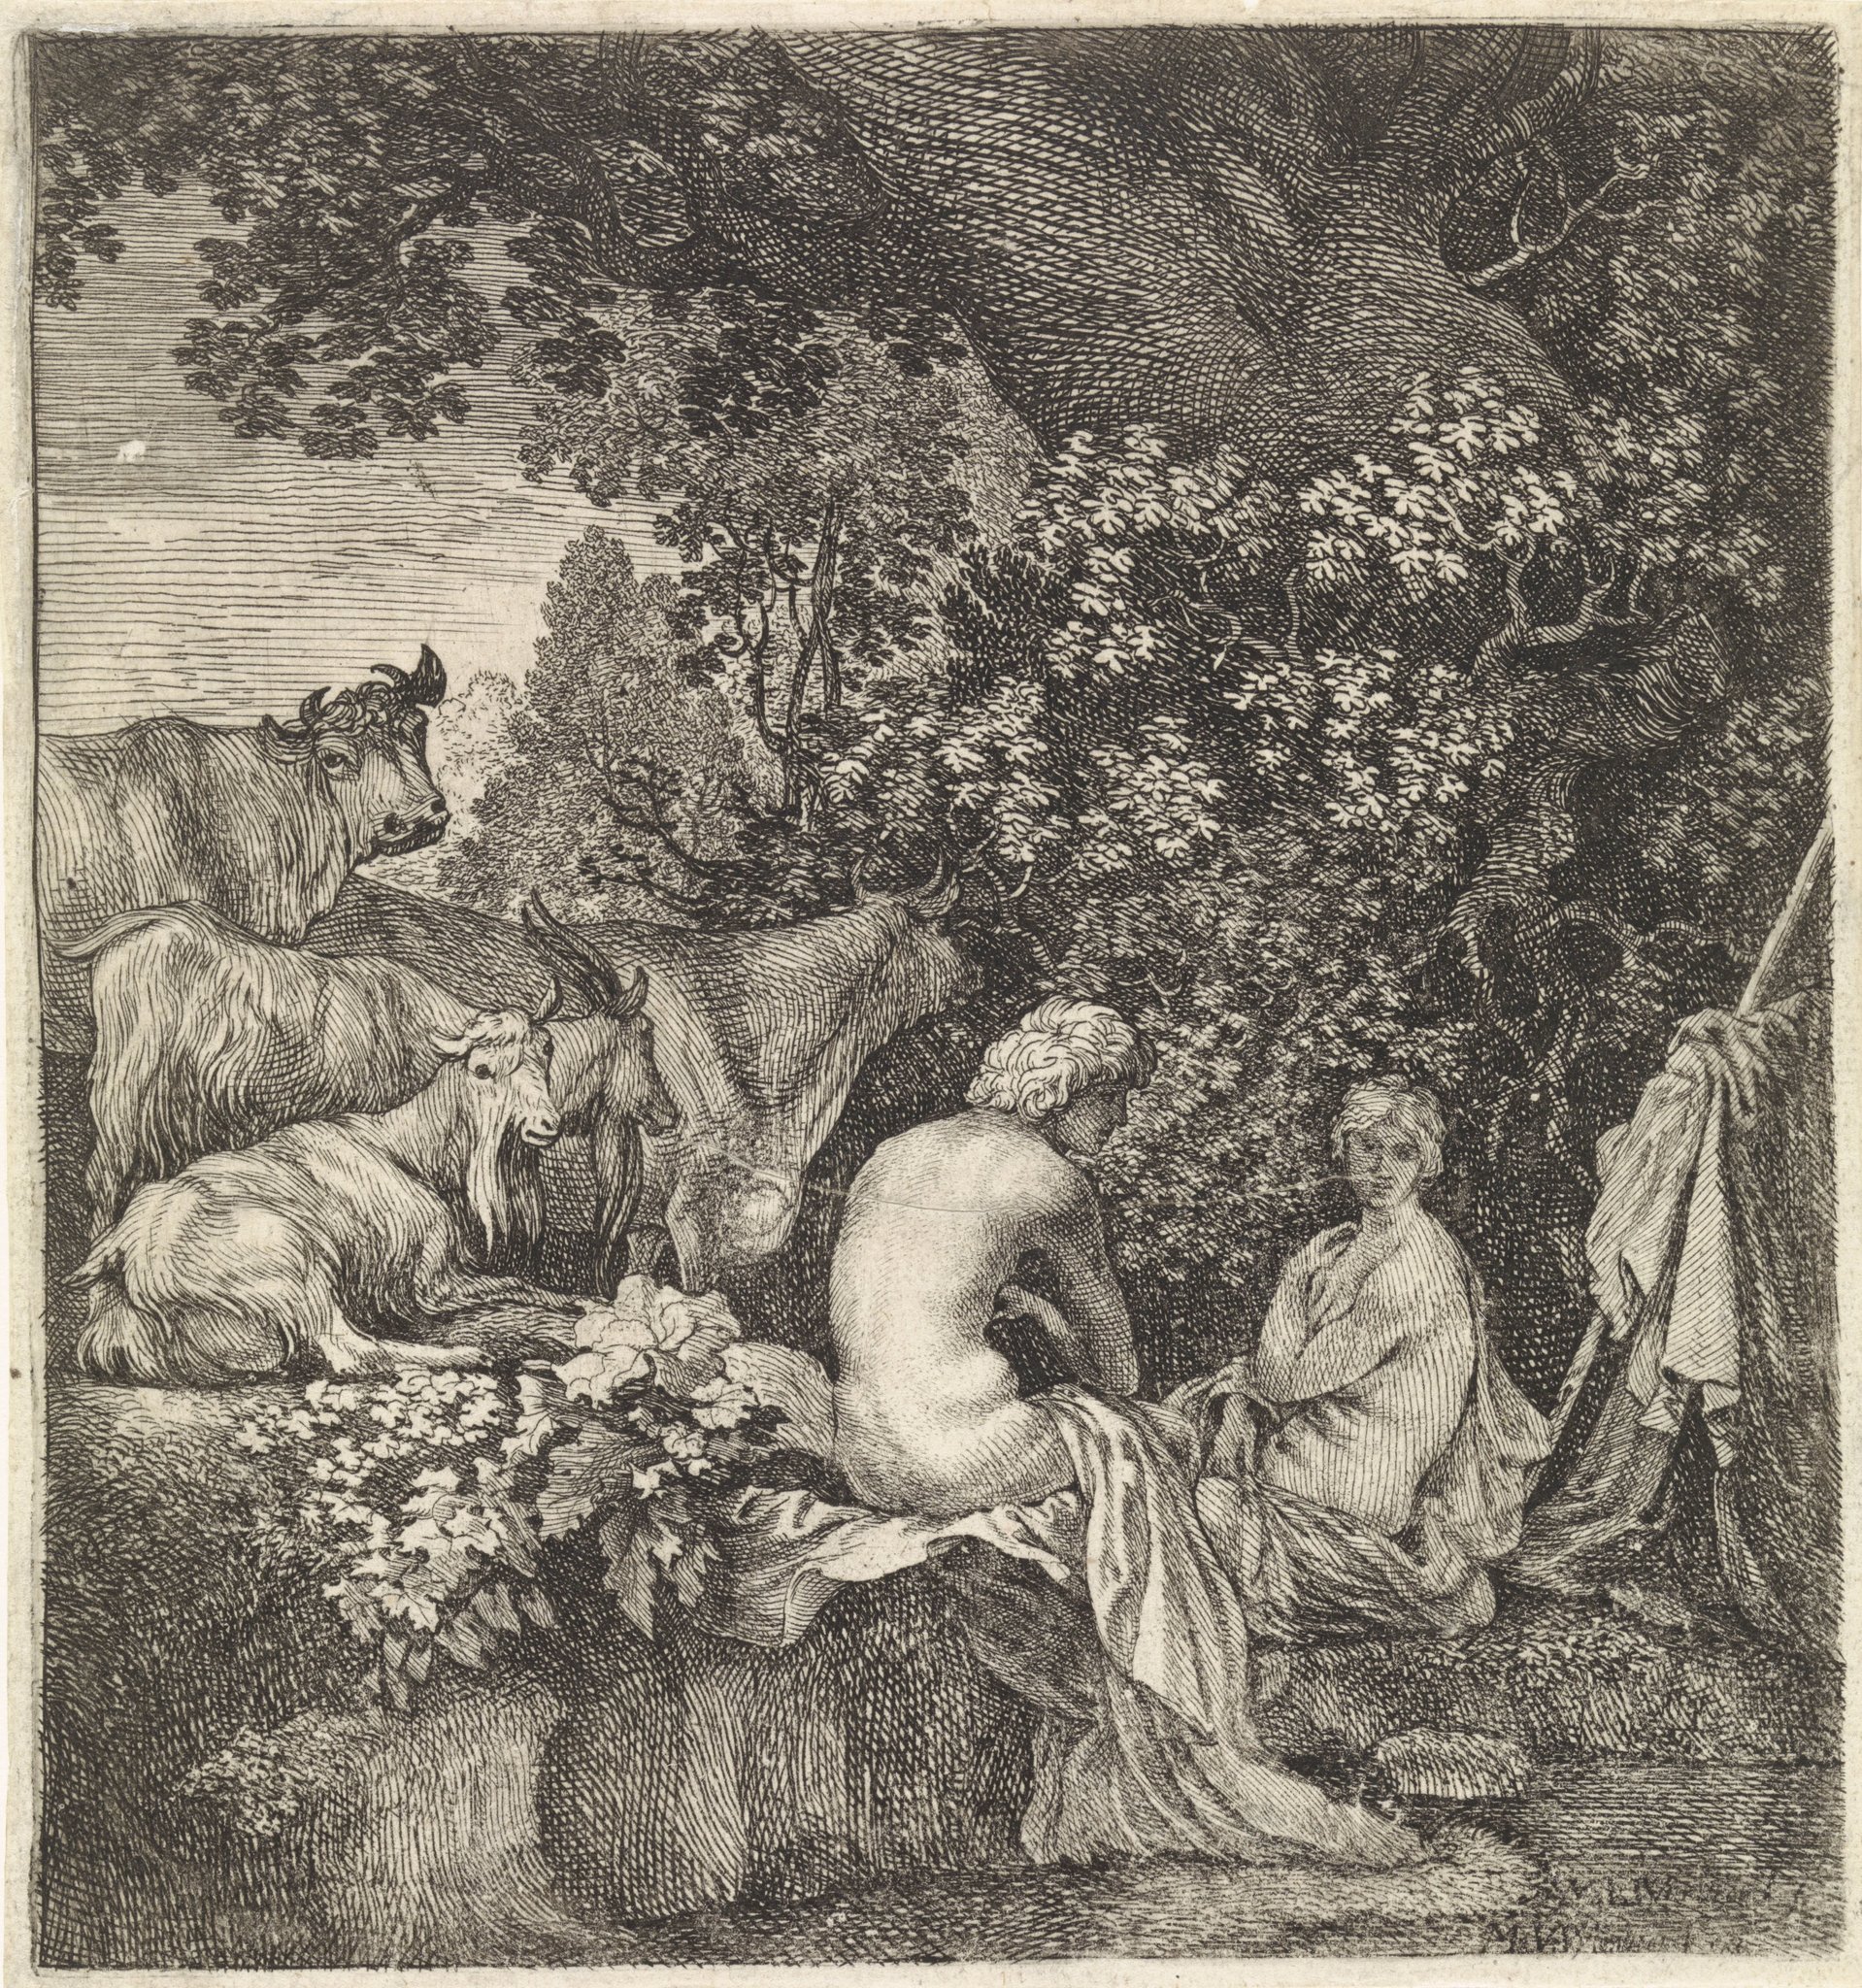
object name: print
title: Herders bij een vijver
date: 1600-1647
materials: paper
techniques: engraving, etching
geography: antwerp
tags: pond, pool, pastorals, arcadian scenes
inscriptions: collector's mark: Lugt 240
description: Een naakte man en vrouw zitten op hun kleding aan de rand van een vijver. Achter hen hun kudde.